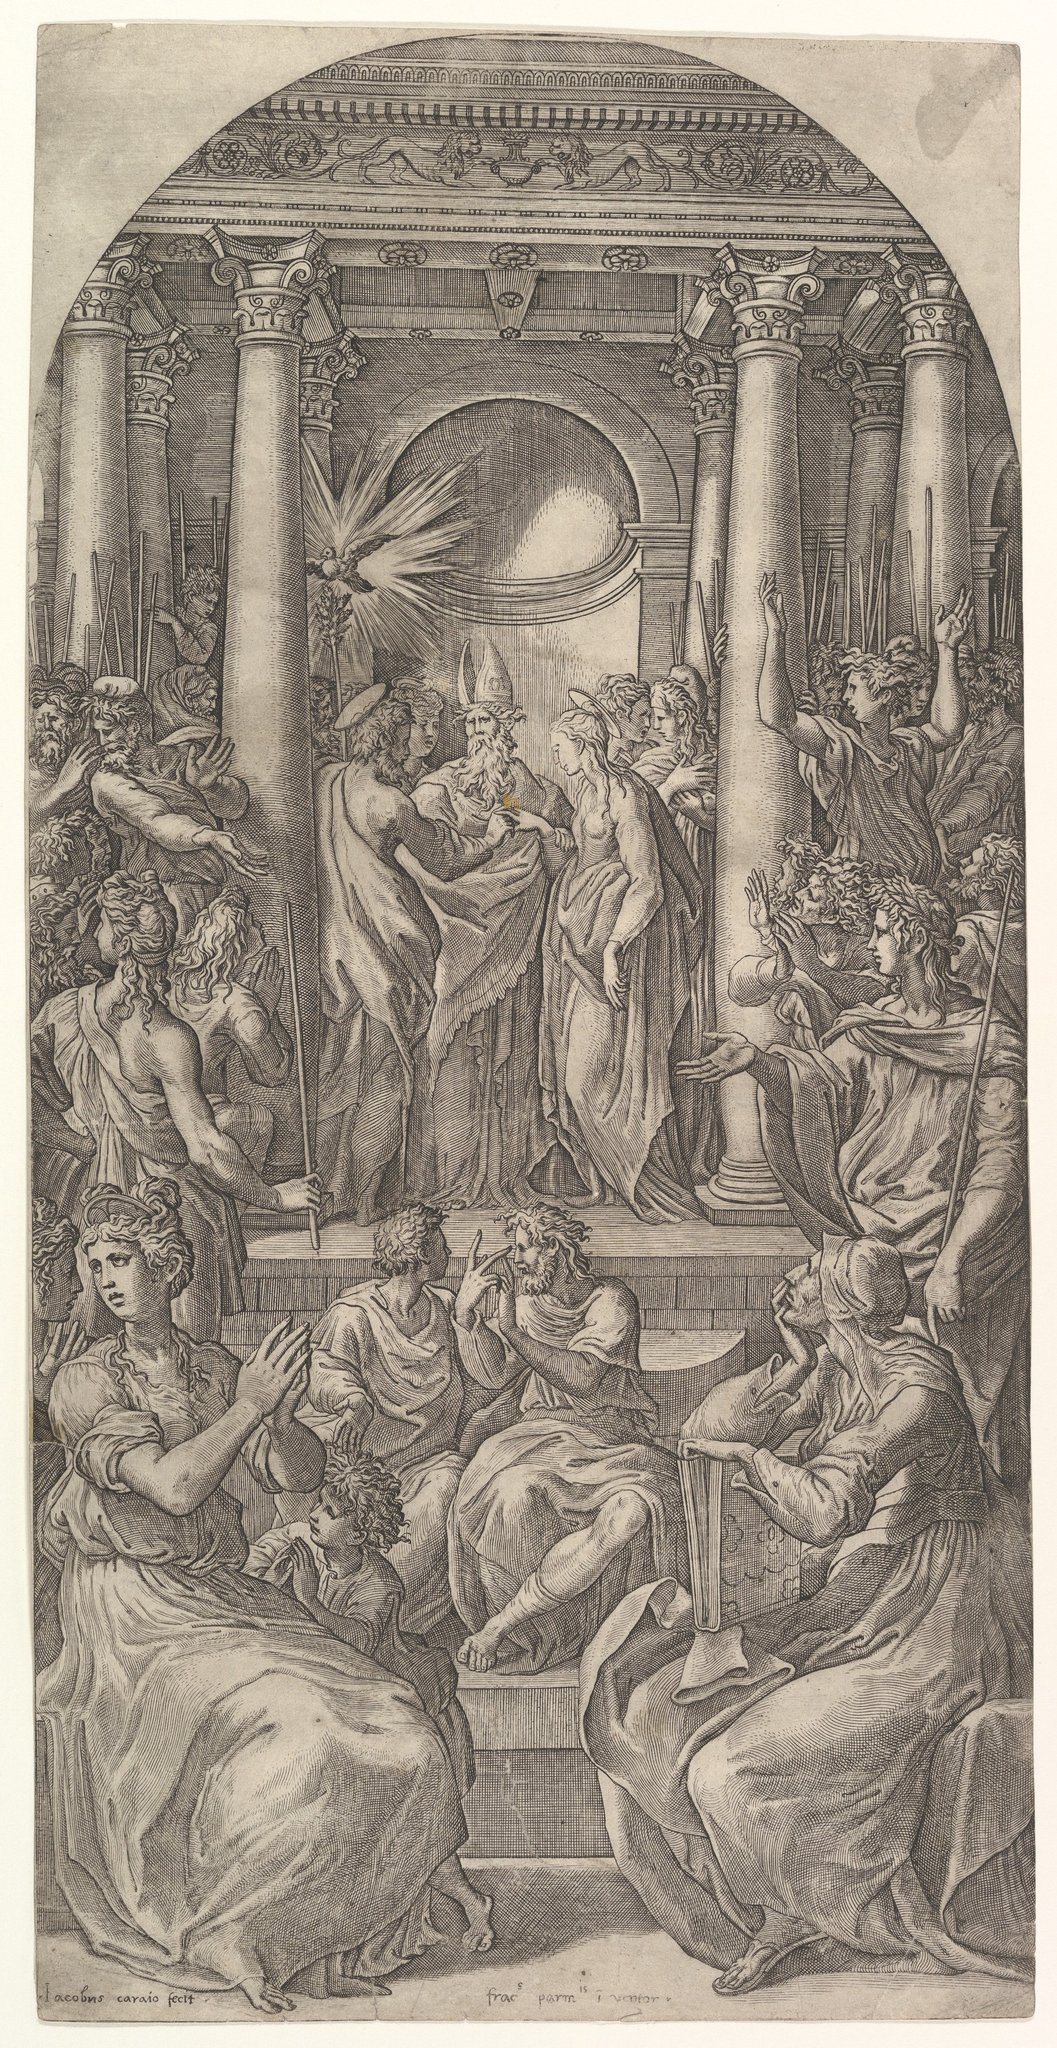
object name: print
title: The Marriage of the Virgin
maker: giovanni jacopo caraglio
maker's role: artist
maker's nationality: italian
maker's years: 1500-1565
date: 1525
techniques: engraving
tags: men,women,virgin mary